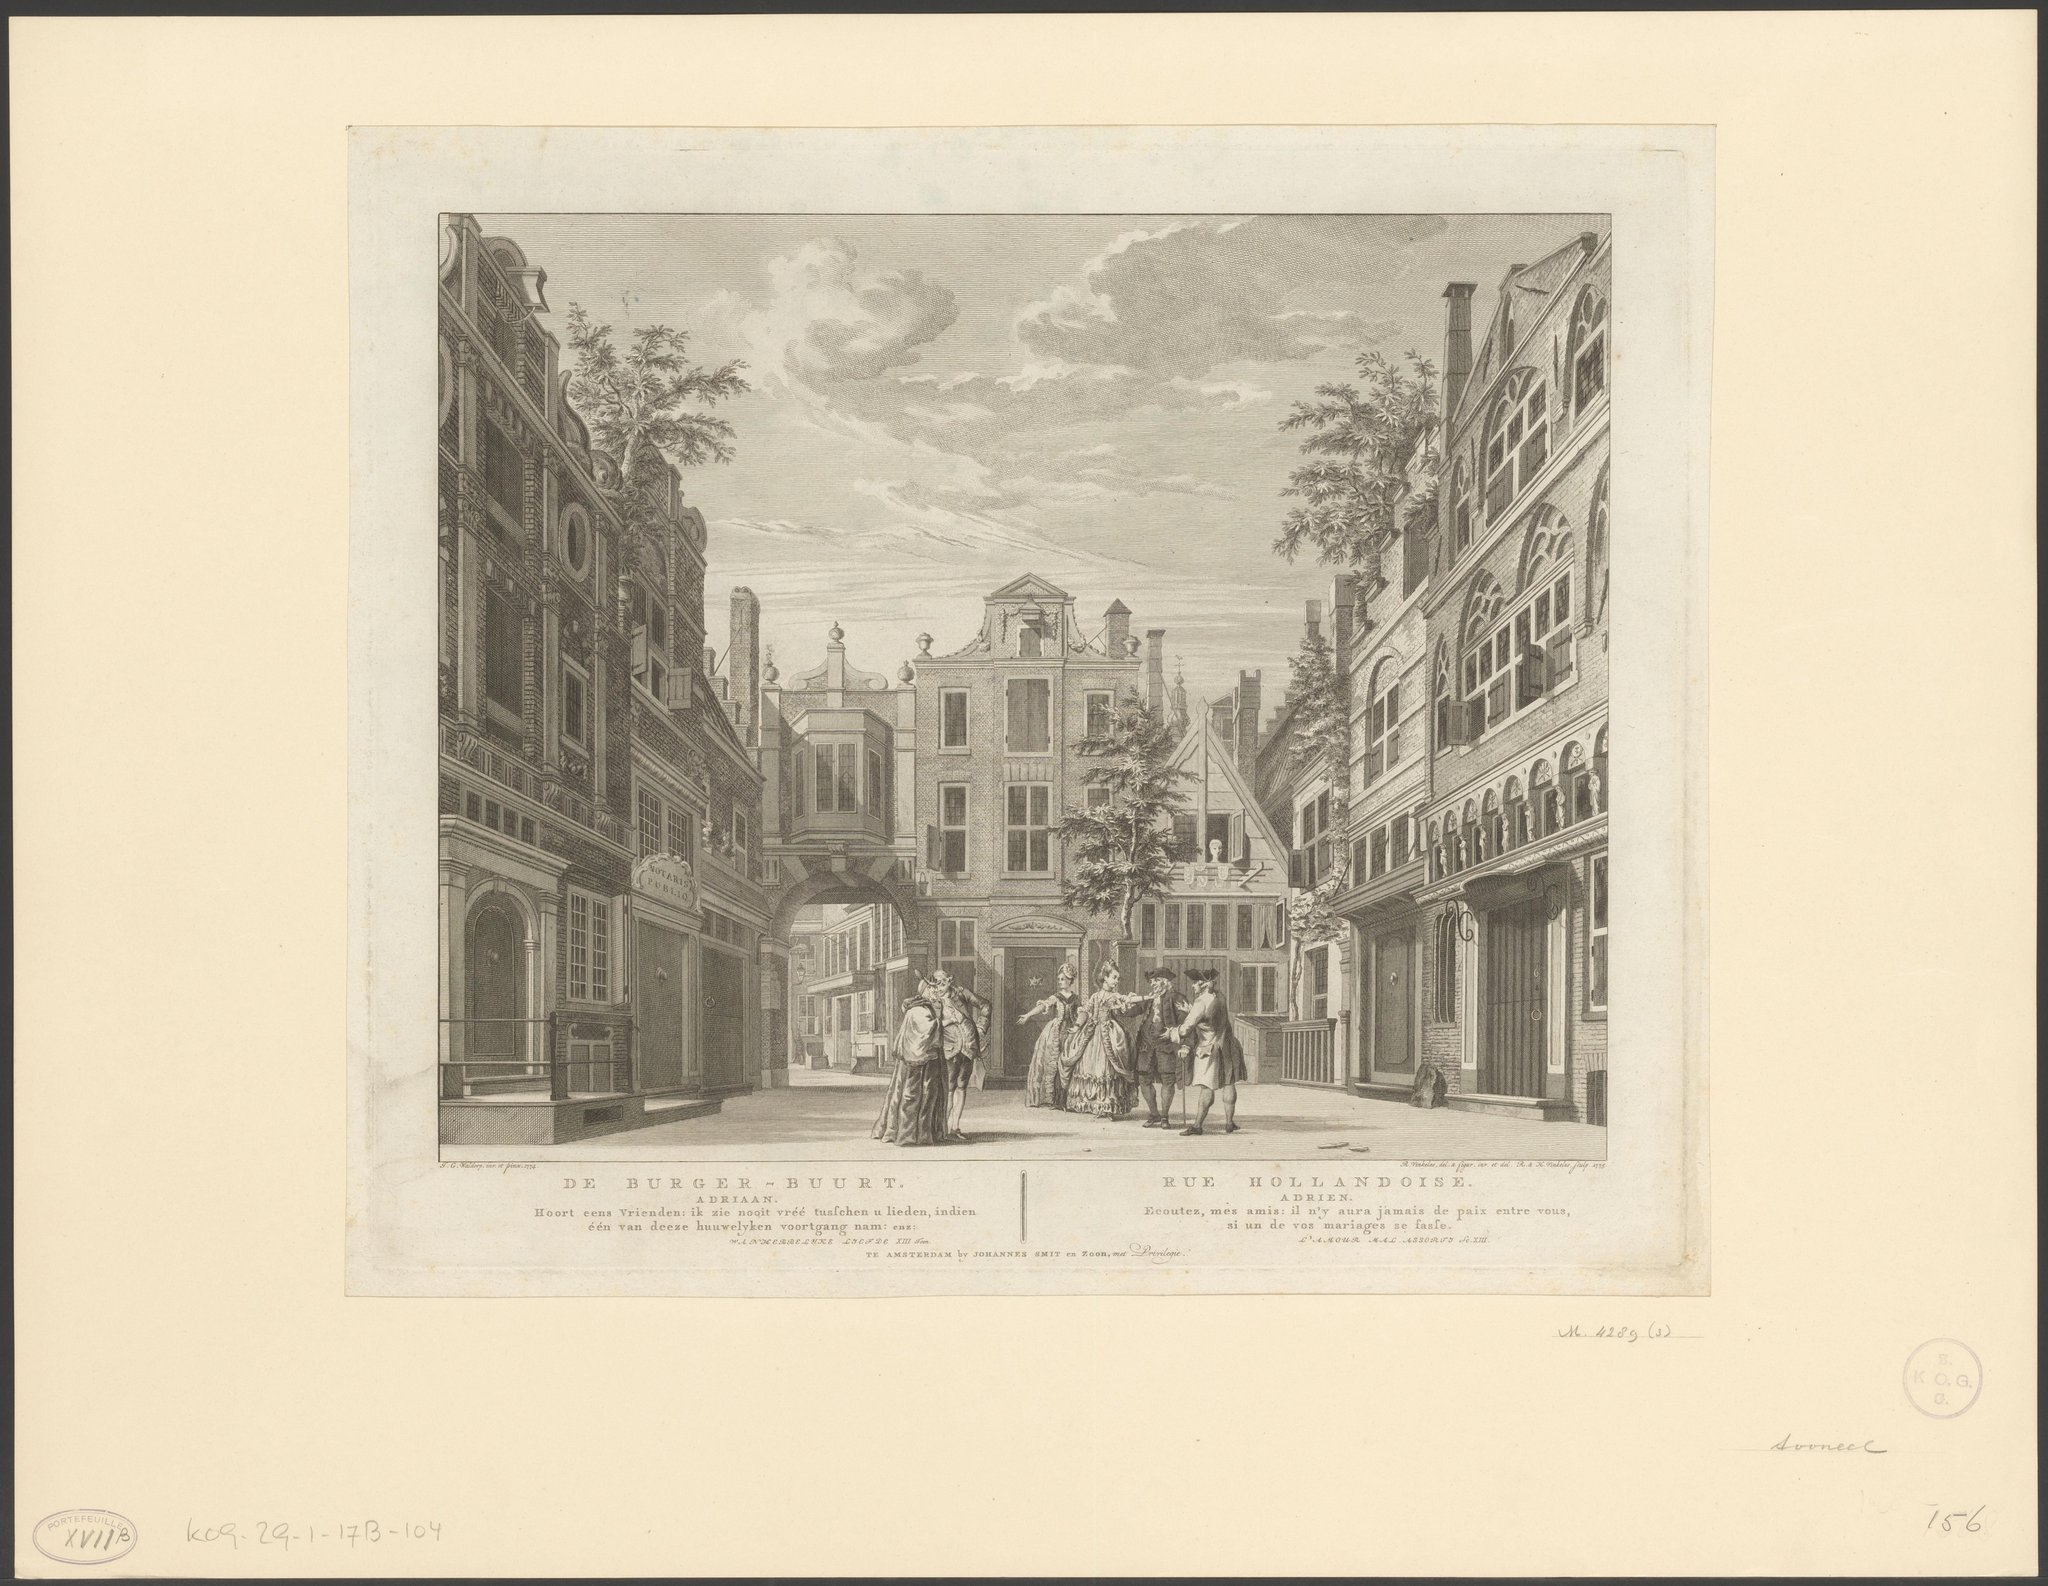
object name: print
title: De Burger-Buurt / Rue Hollandoise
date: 1775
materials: paper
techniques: engraving, etching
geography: amsterdam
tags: theatre, theatrical performance, stage design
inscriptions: collector's mark: Lugt 1641, stamp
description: Het coulissendecor De Burger-Buurt, met een scène uit: Wanhebbelijke Liefde. Onderdeel van een serie van zes toneeldecors van toneelstukken opgevoerd in de nieuwe Amsterdamse Schouwburg uit de jaren 1775-1777. Onderwerpsrubrieken binnen de Atlas Zeden en Gewoonten: Schoone kunsten, Tooneel, Decors voor de Schouwburg.